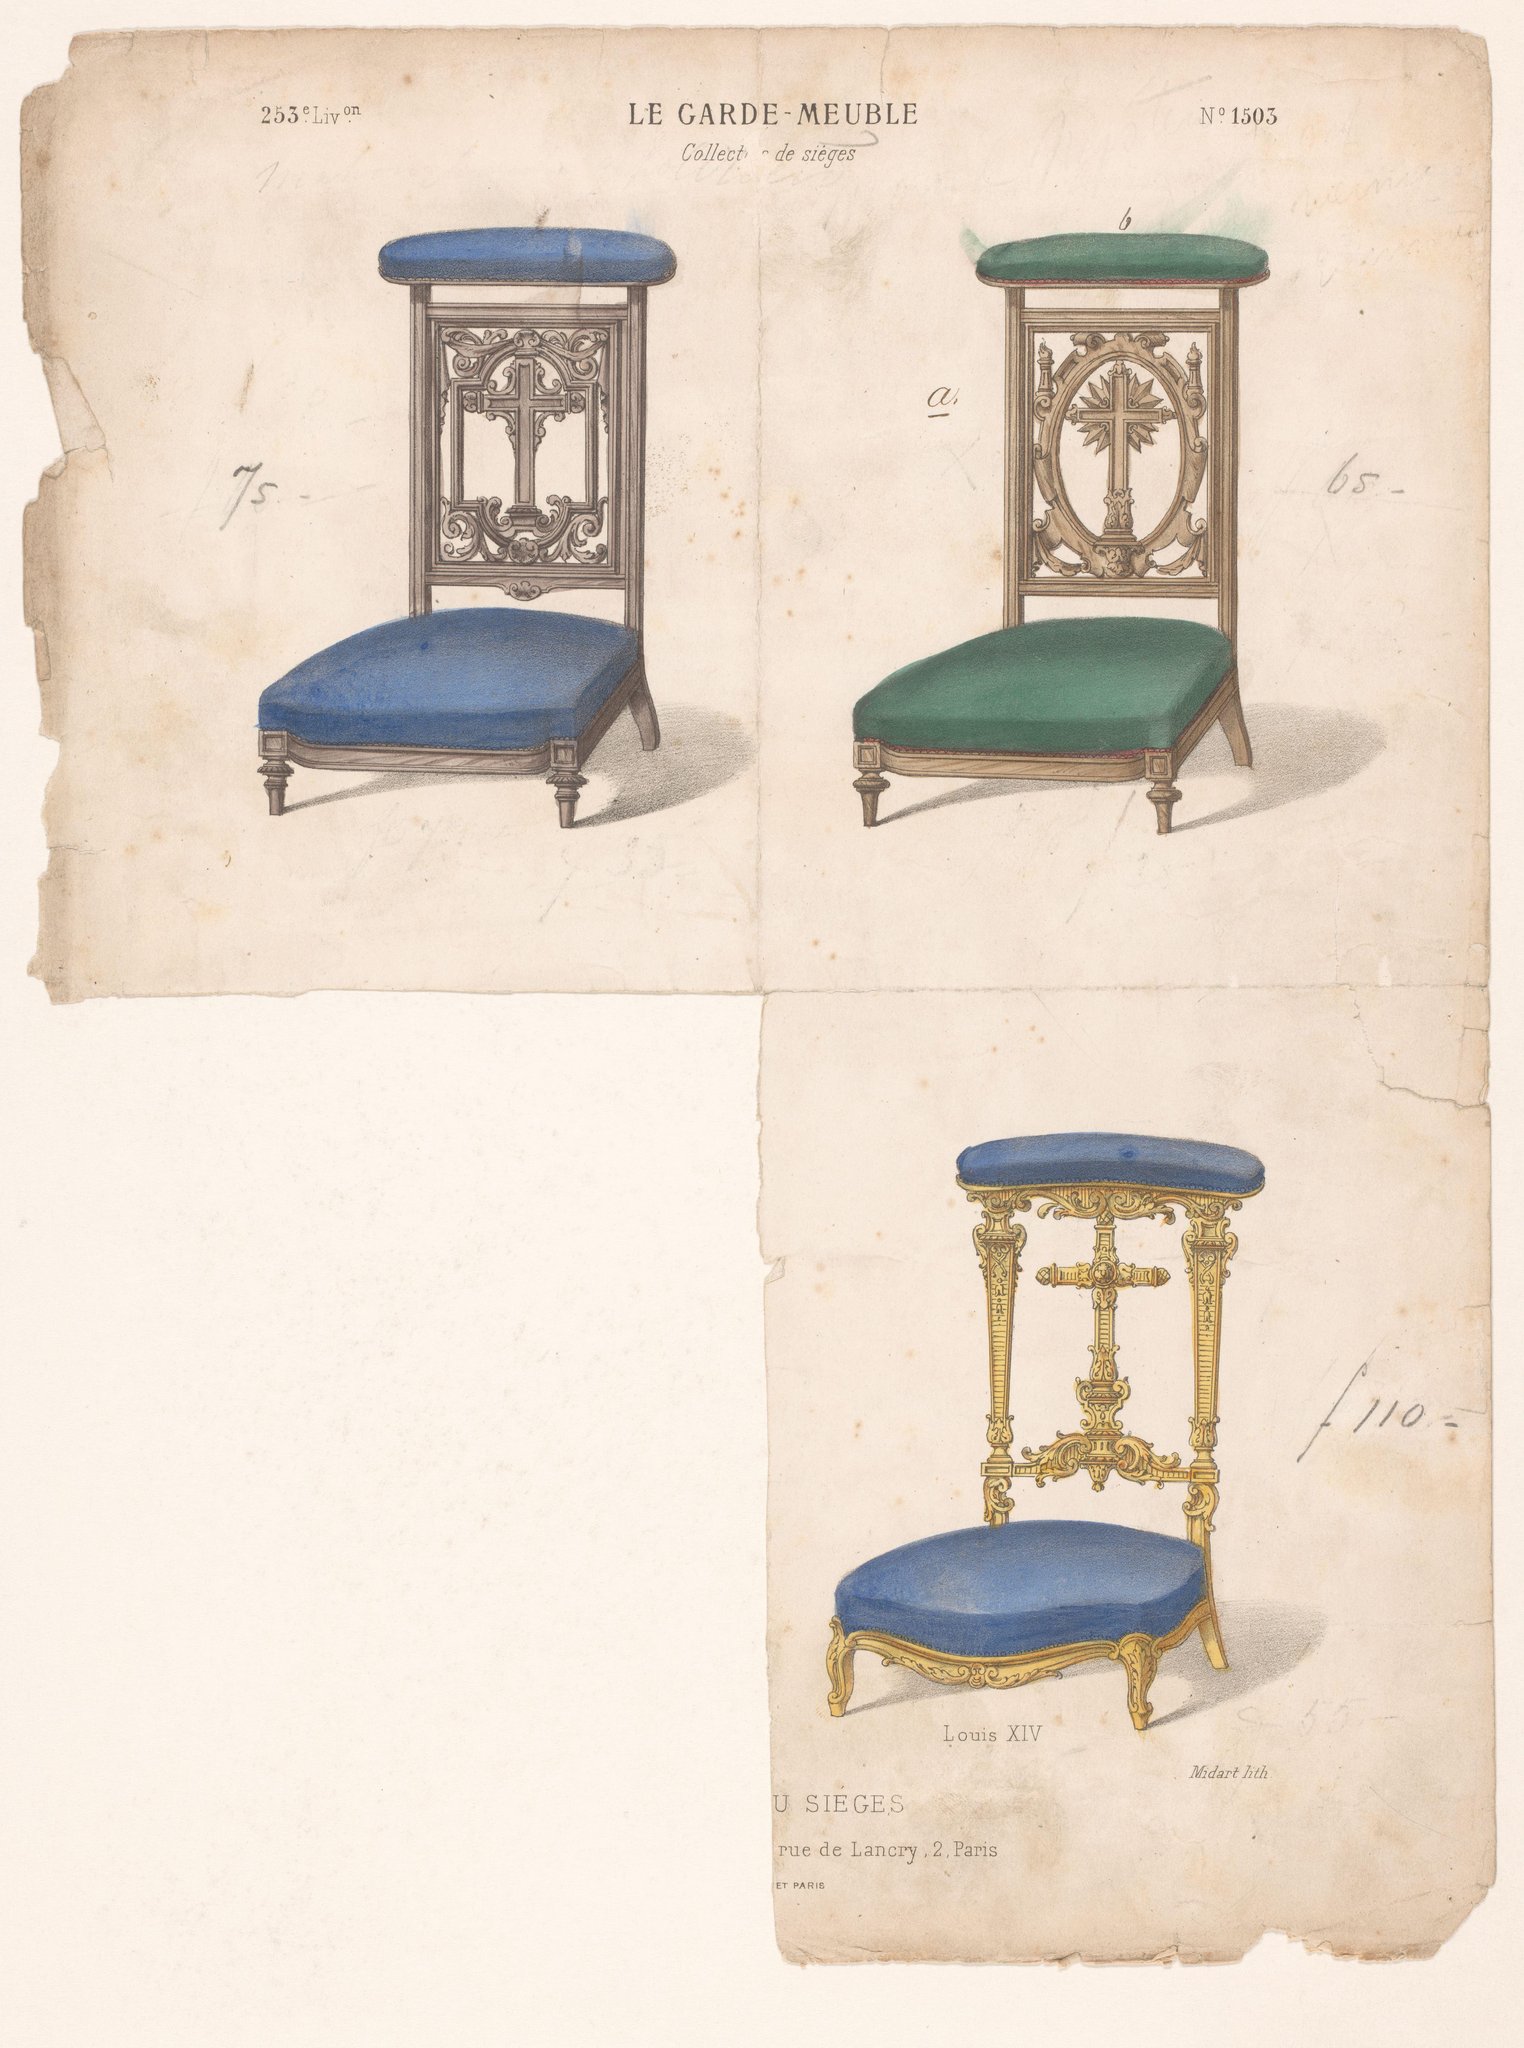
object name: print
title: Drie bidstoelen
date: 1839-1885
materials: paper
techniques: hand coloring, lithograph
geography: paris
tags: seating furniture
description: Ieder Livraison in de serie Le Garde-Meuble bevat negen platen: drie 'sièges' (zitmeubels), drie 'meubles' (diverse meubels zoals tafels en kasten) en drie 'tentures' (gordijnen en draperieën).